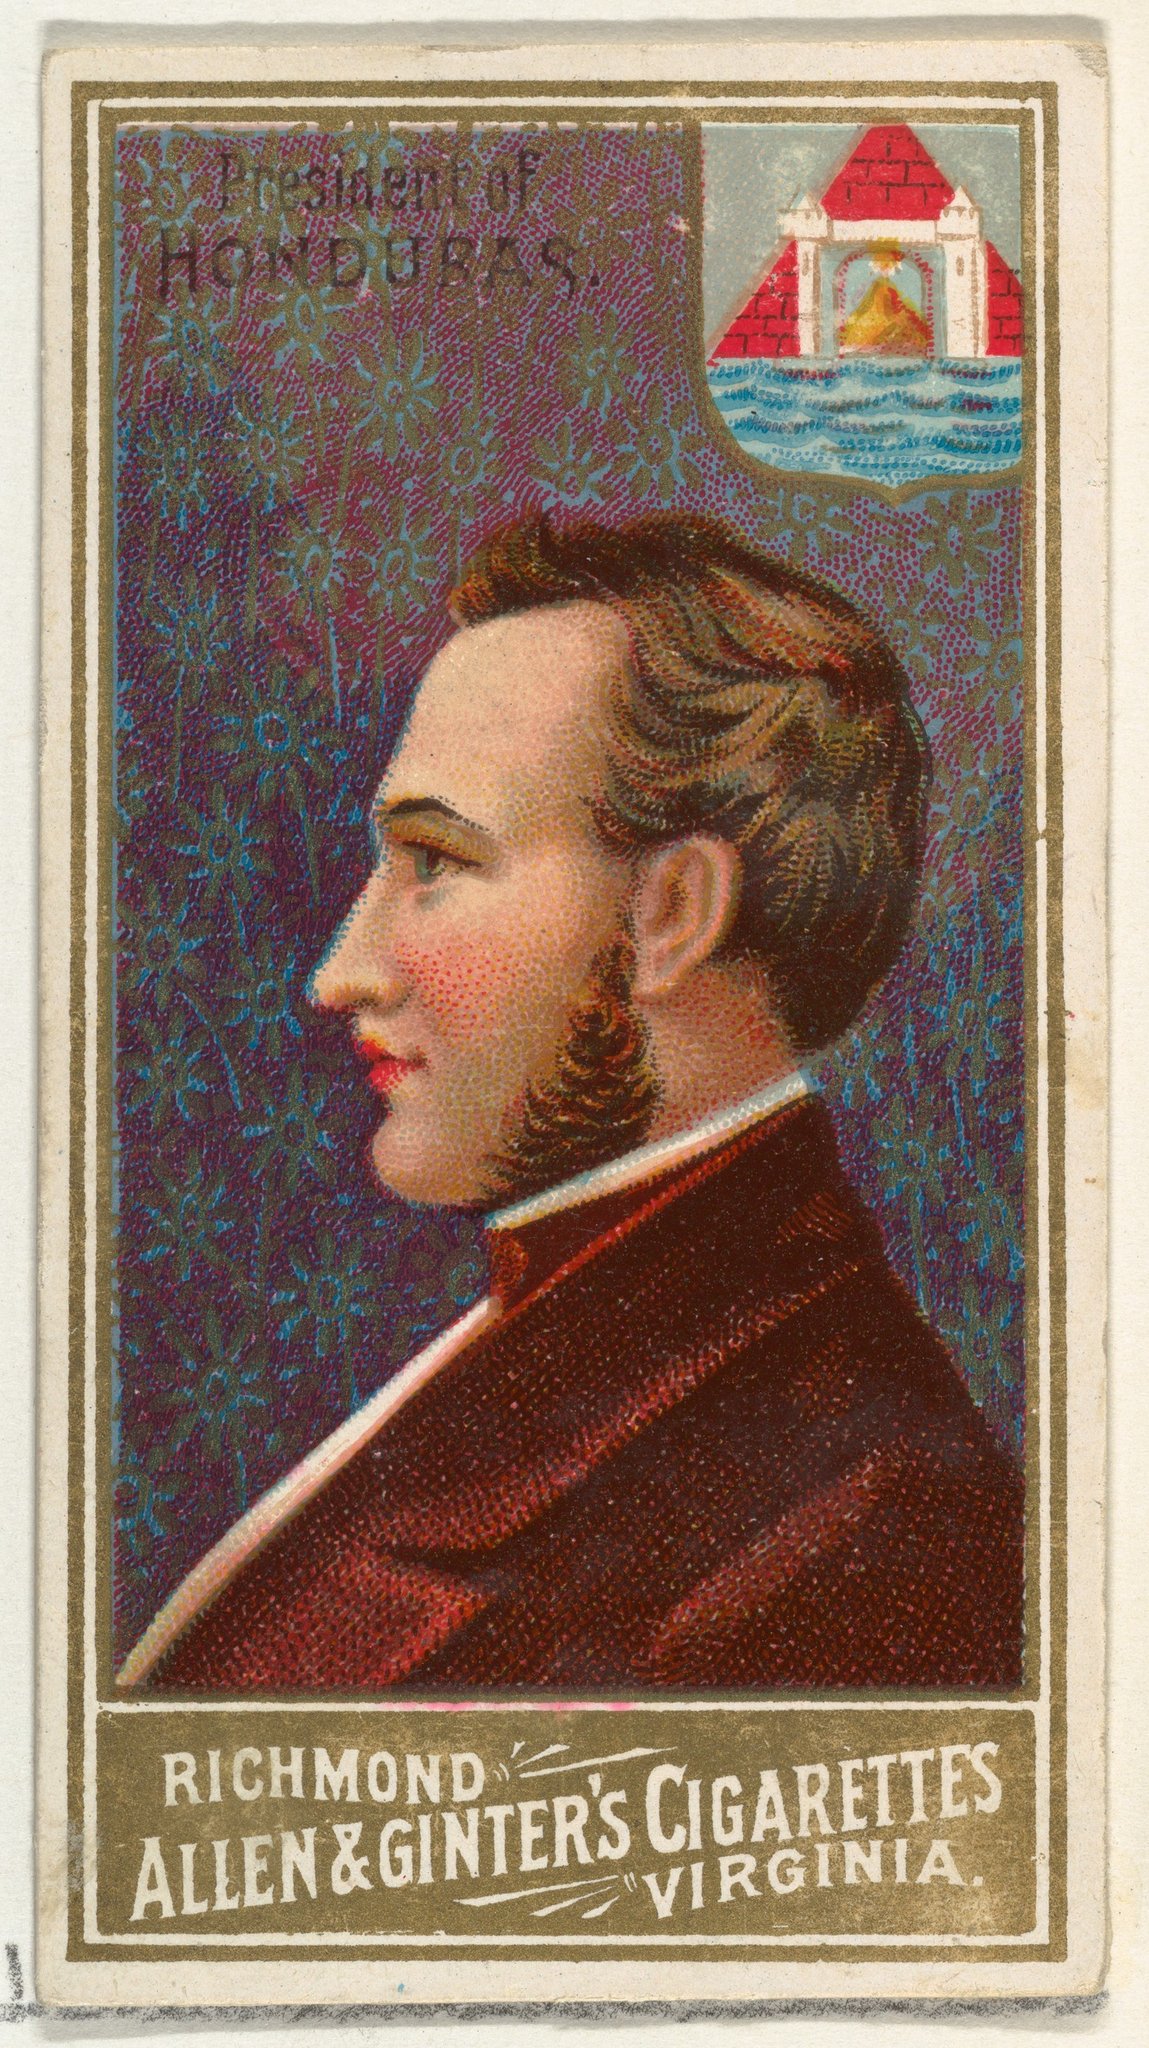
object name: print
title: President of Honduras, from World's Sovereigns series (N34) for Allen & Ginter Cigarettes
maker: allen & ginter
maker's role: publisher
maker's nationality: american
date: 1889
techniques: color lithograph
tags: men,profiles